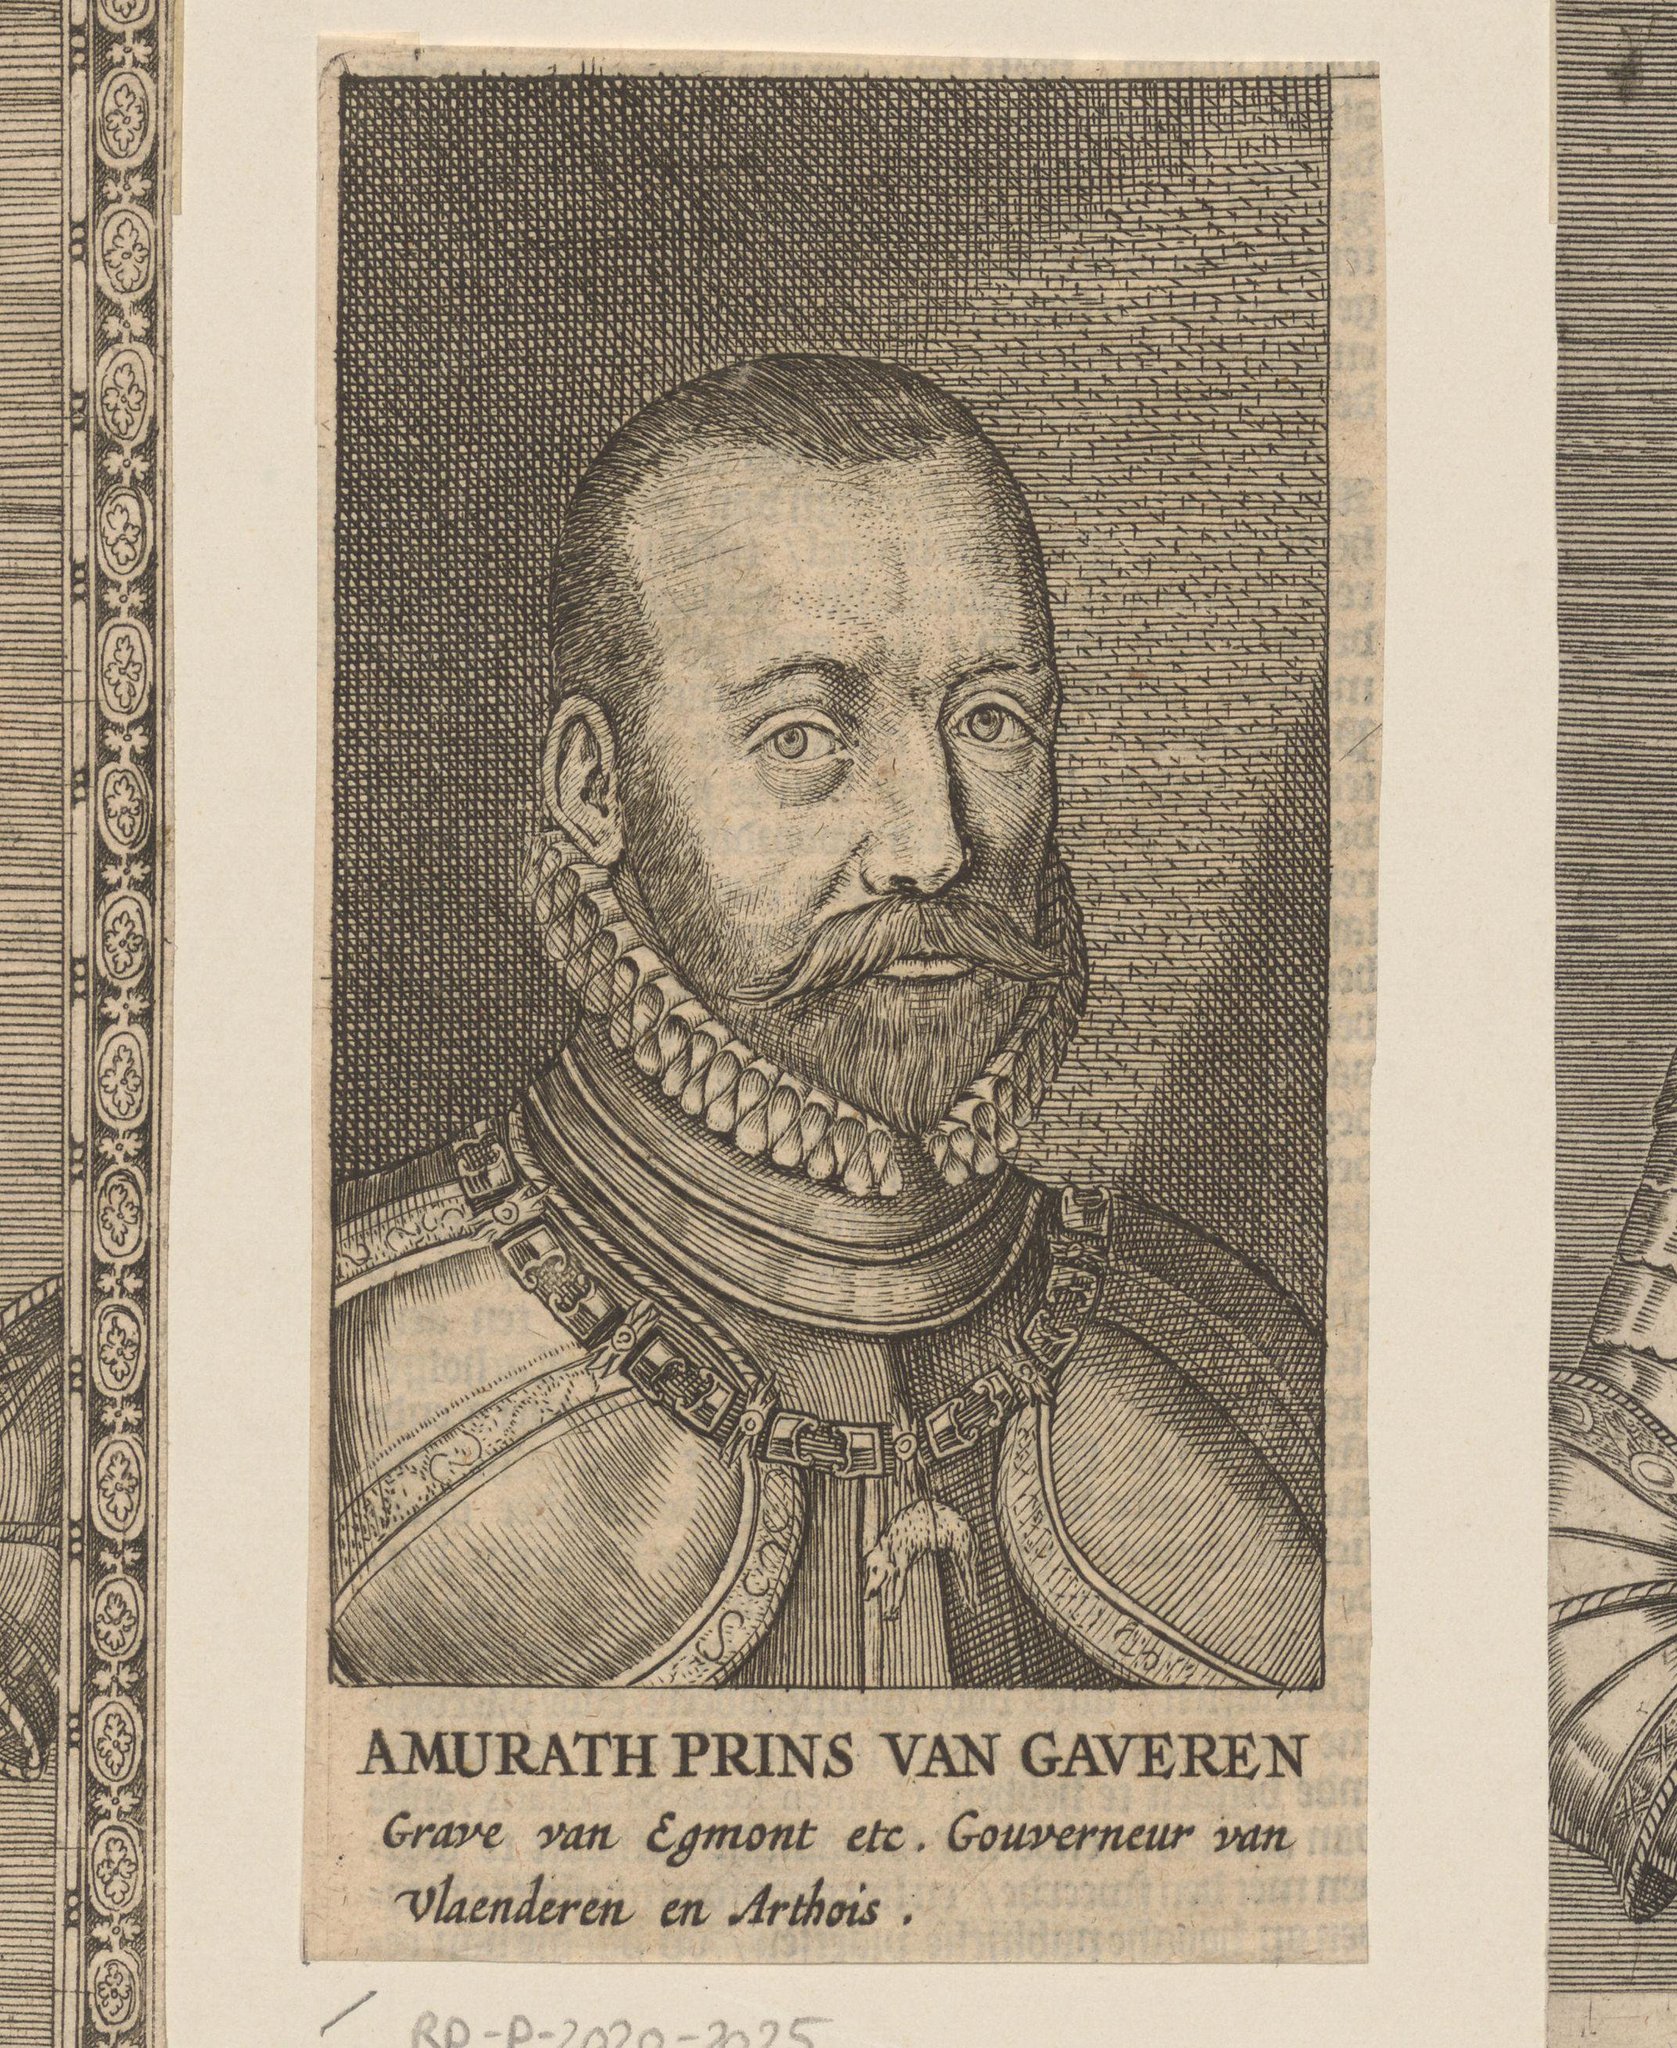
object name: print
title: Portret van Lamoraal van Egmond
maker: Anonymous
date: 1611-1620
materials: paper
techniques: engraving, letterpress printing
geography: northern netherlands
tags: earl, armour, historical persons, knighthood order of the golden fleece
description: Prent komt mogelijk uit een herdruk van: Meteren, Emanuel van. Nederlantsche historien ofte geschiedenissen (...). S.l.s.n., 1611.